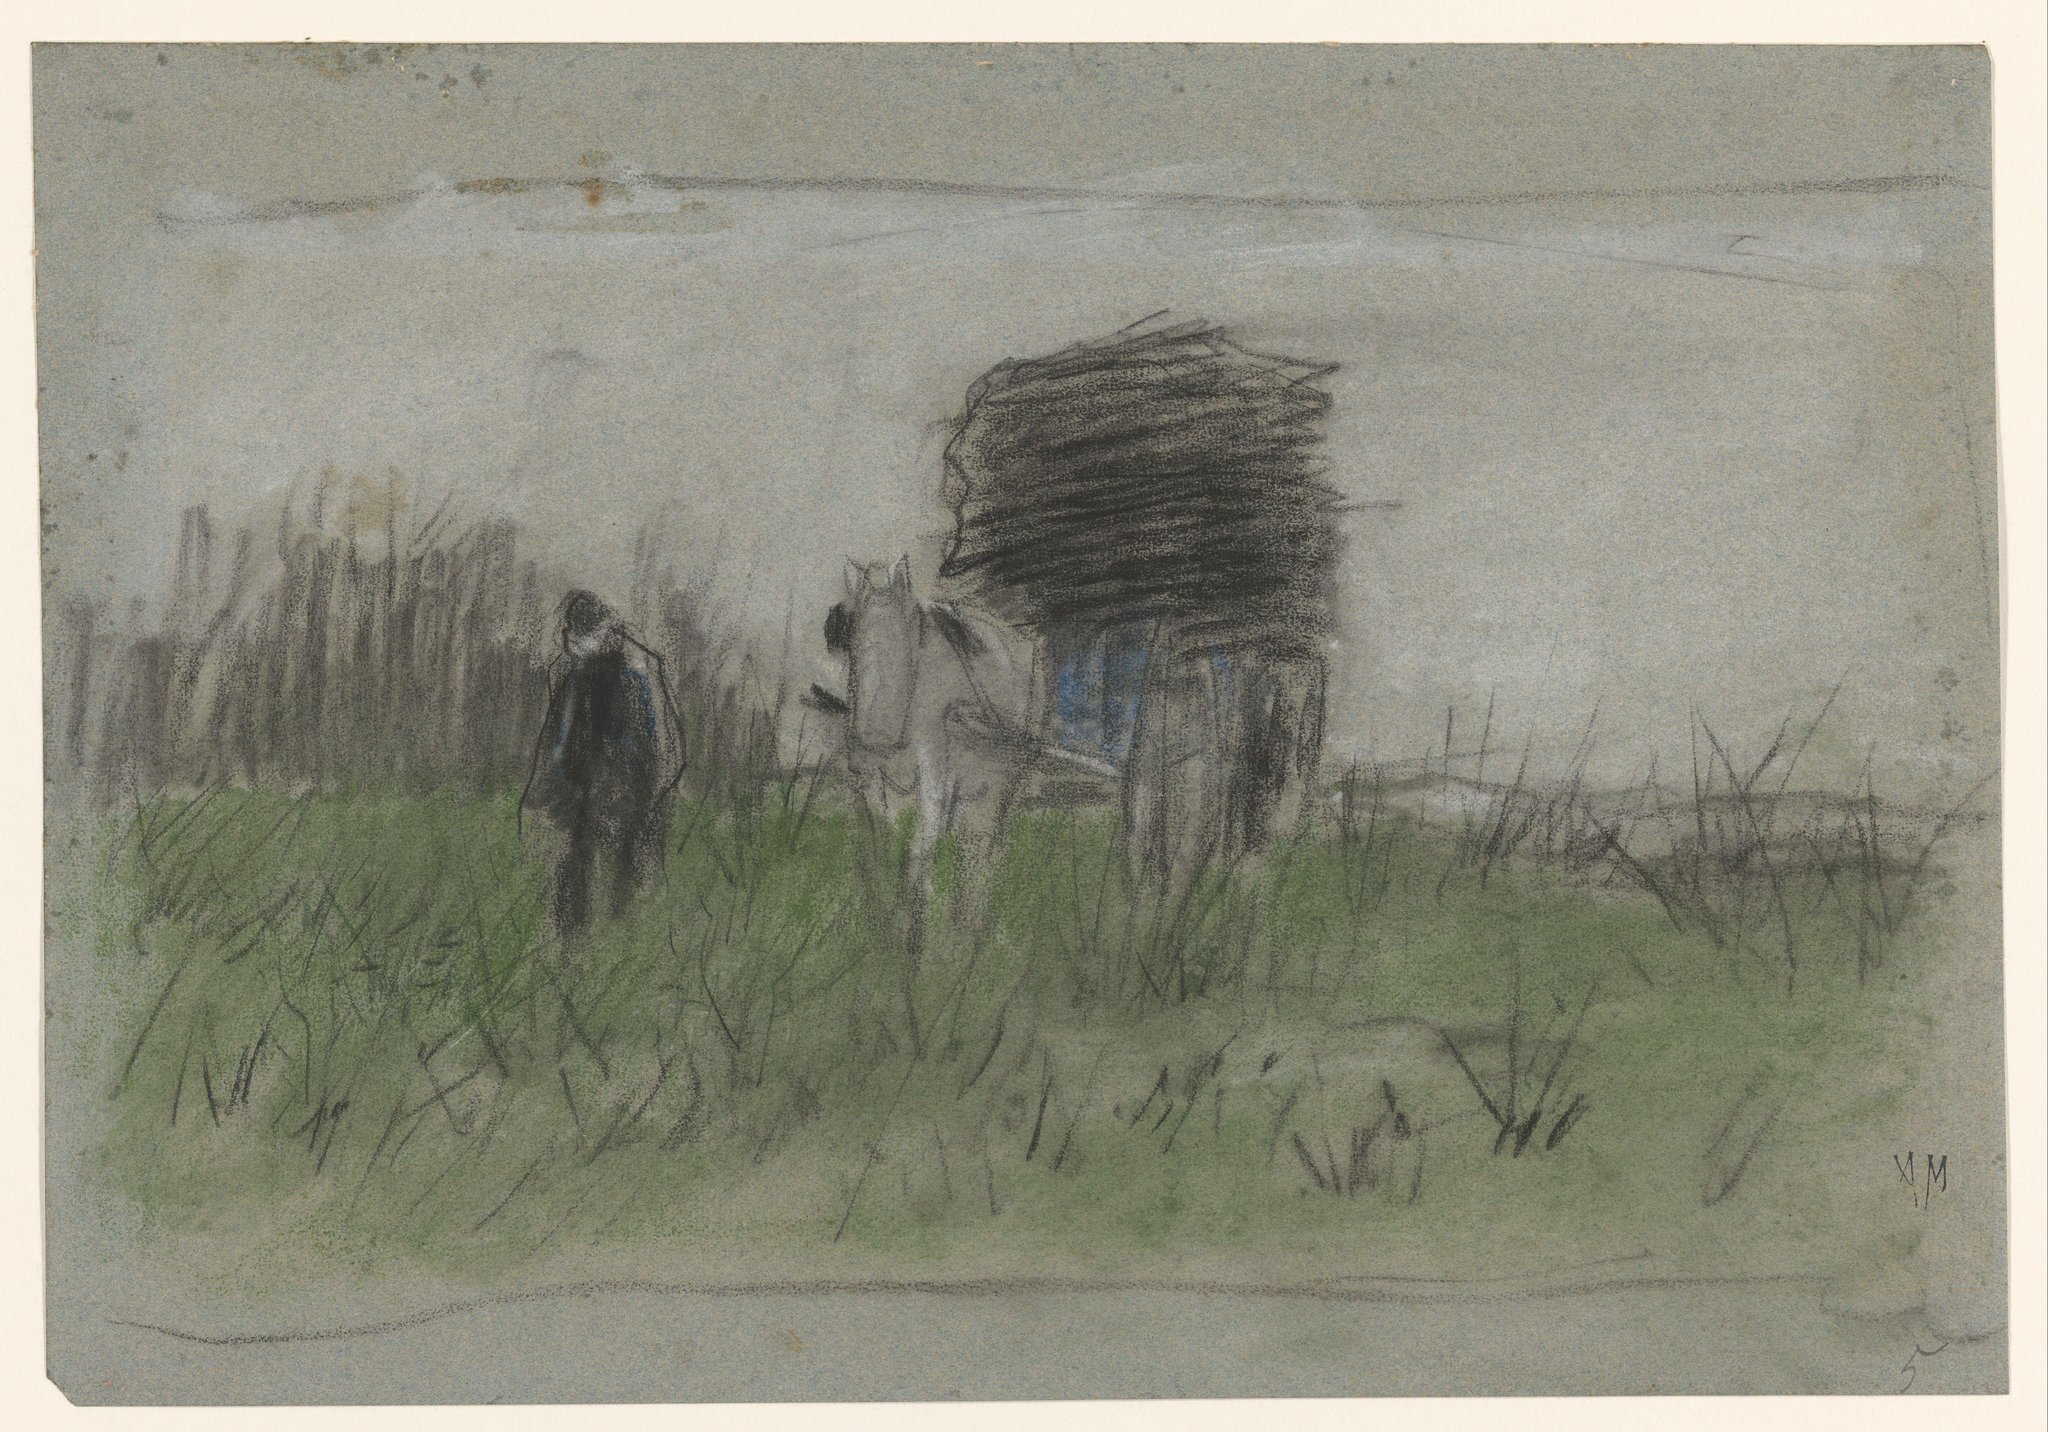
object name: drawing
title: Man met paard en wagen in de duinen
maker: anton mauve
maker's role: draughtsman, painter, print maker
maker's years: 1838-1888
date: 1848-1888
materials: chalk, paper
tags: dunes (sea not visible); in the dunes, (farm) wagon, freight wagon, cart